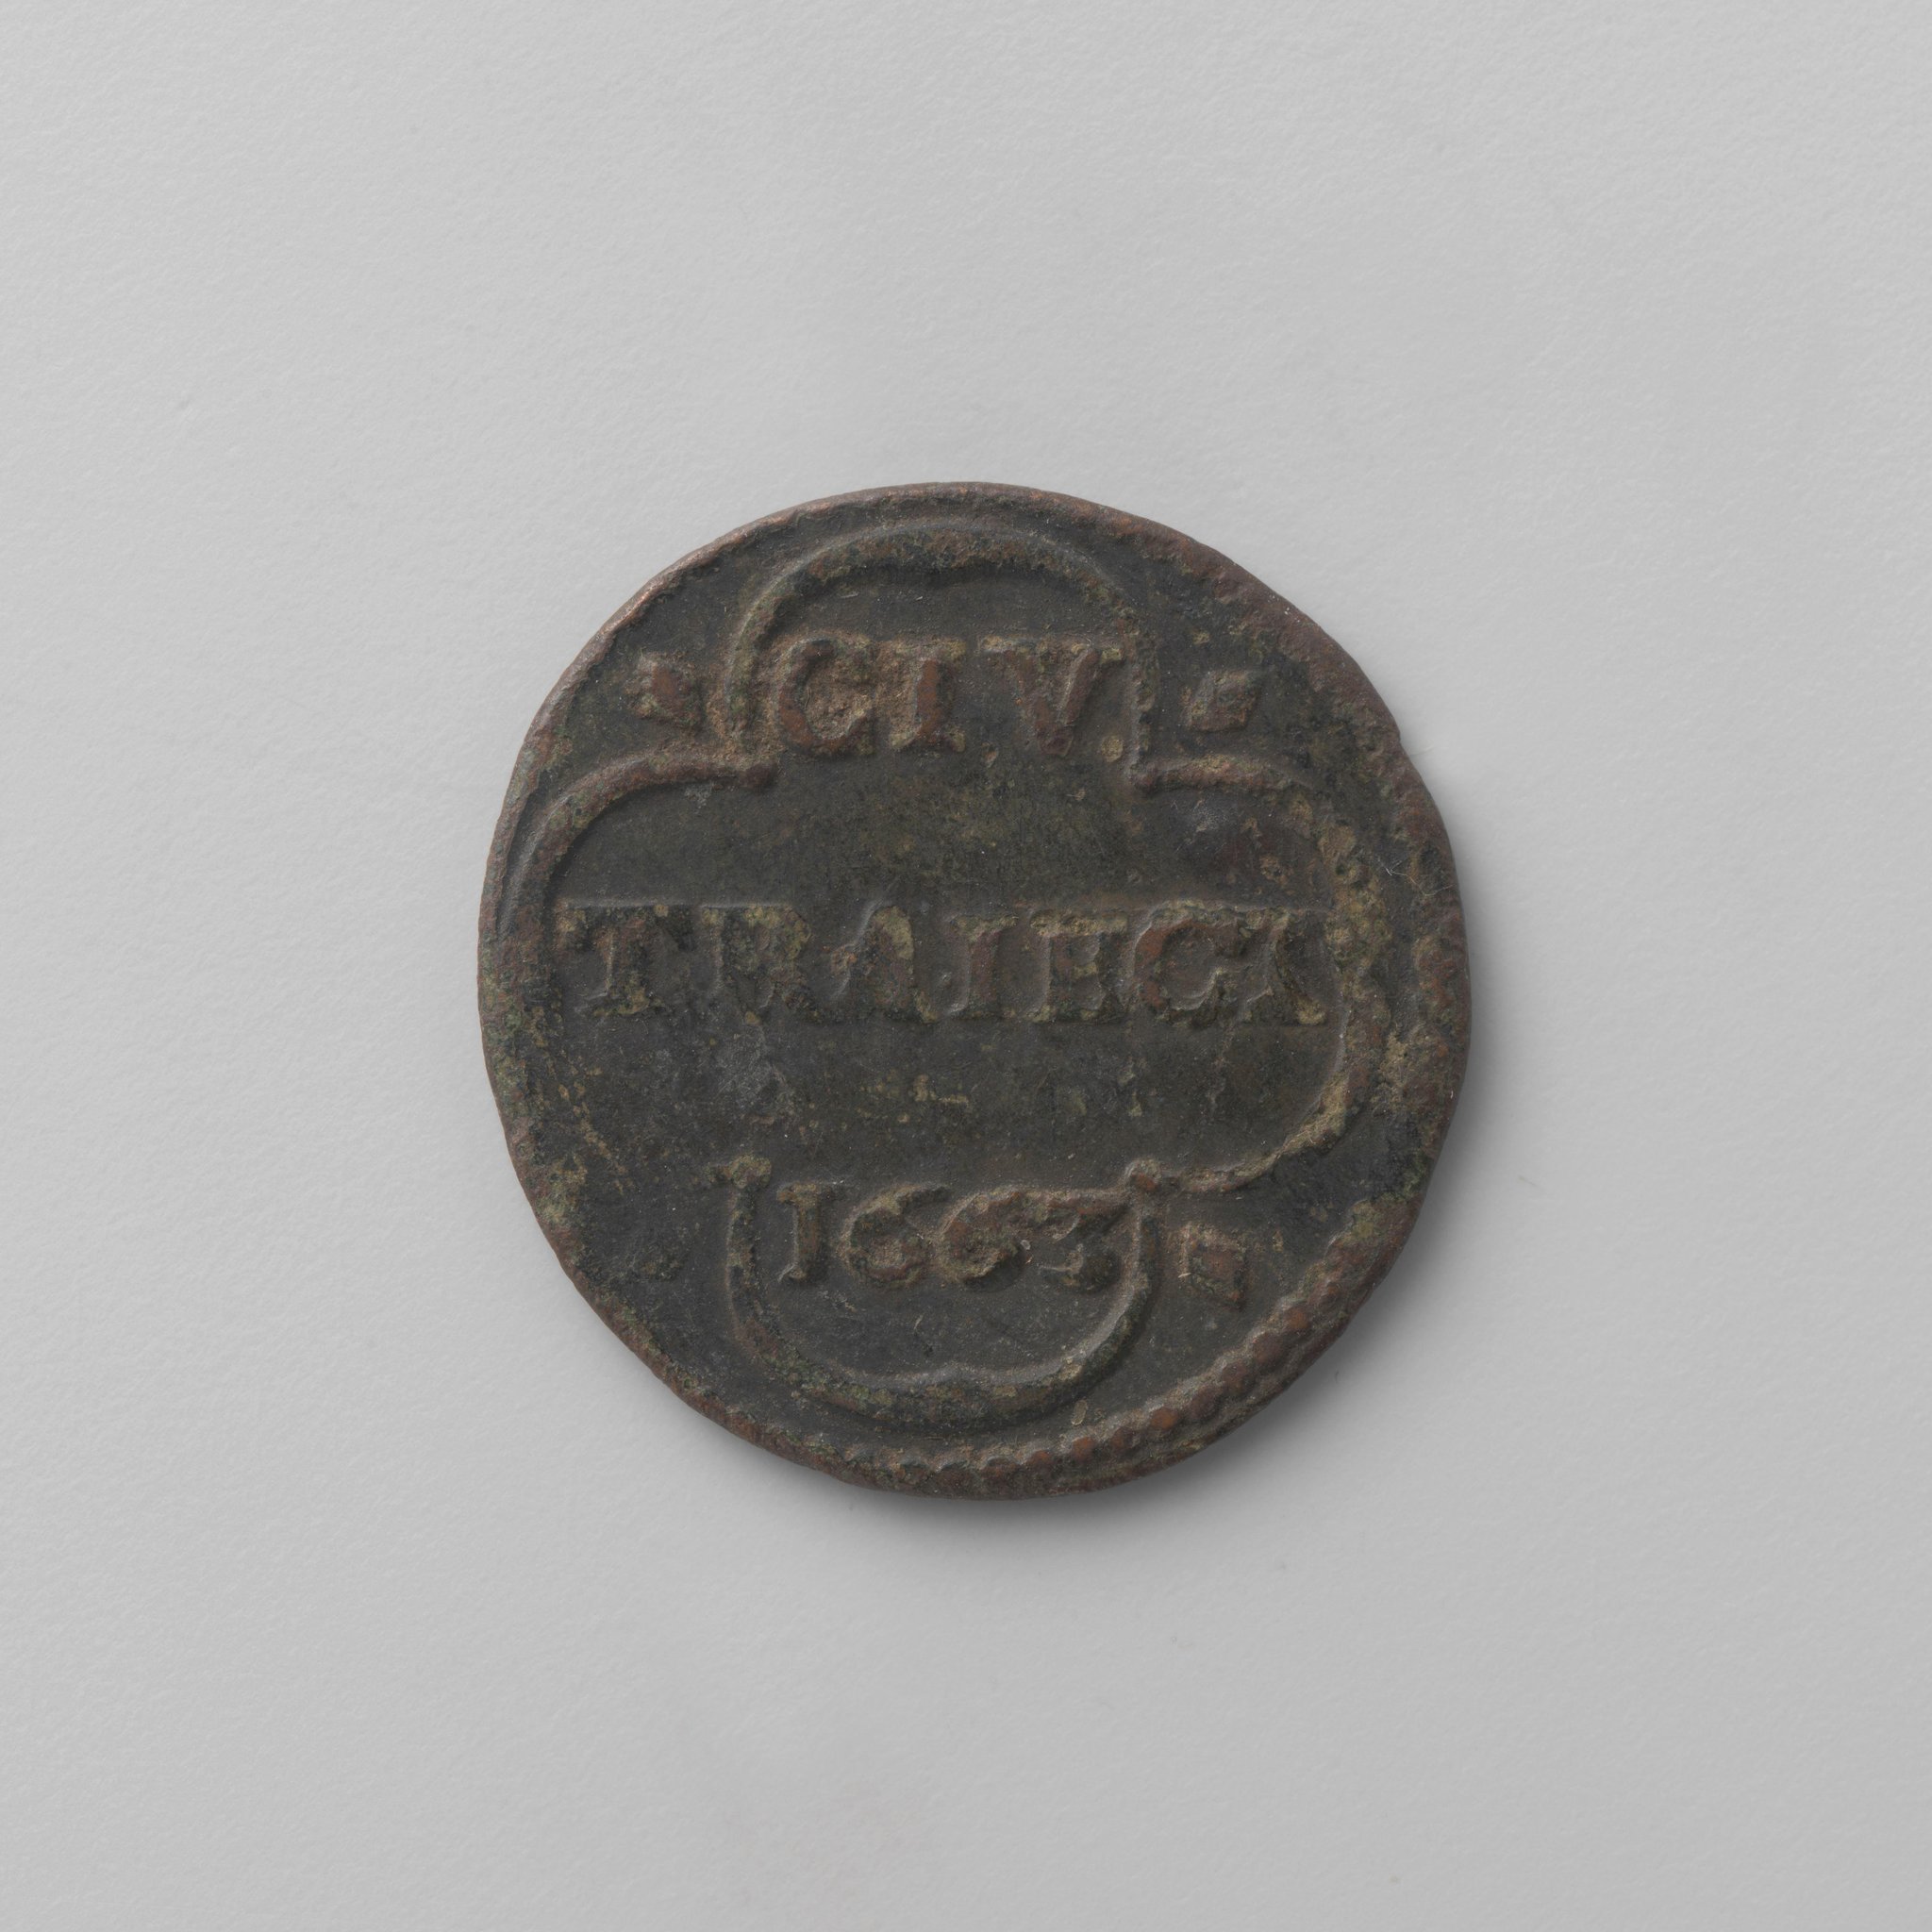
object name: coin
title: Stad Utrecht, duit, 1663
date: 1663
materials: copper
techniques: striking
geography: utrecht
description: Koperen munt. Voorzijde: gekroond stedelijk, horizontaal gearceeerd wapenschild, gehouden door twee leeuwen. Keerzijde: binnen een versierde vierpas opschrift in twee regels, waaronder jaartal.